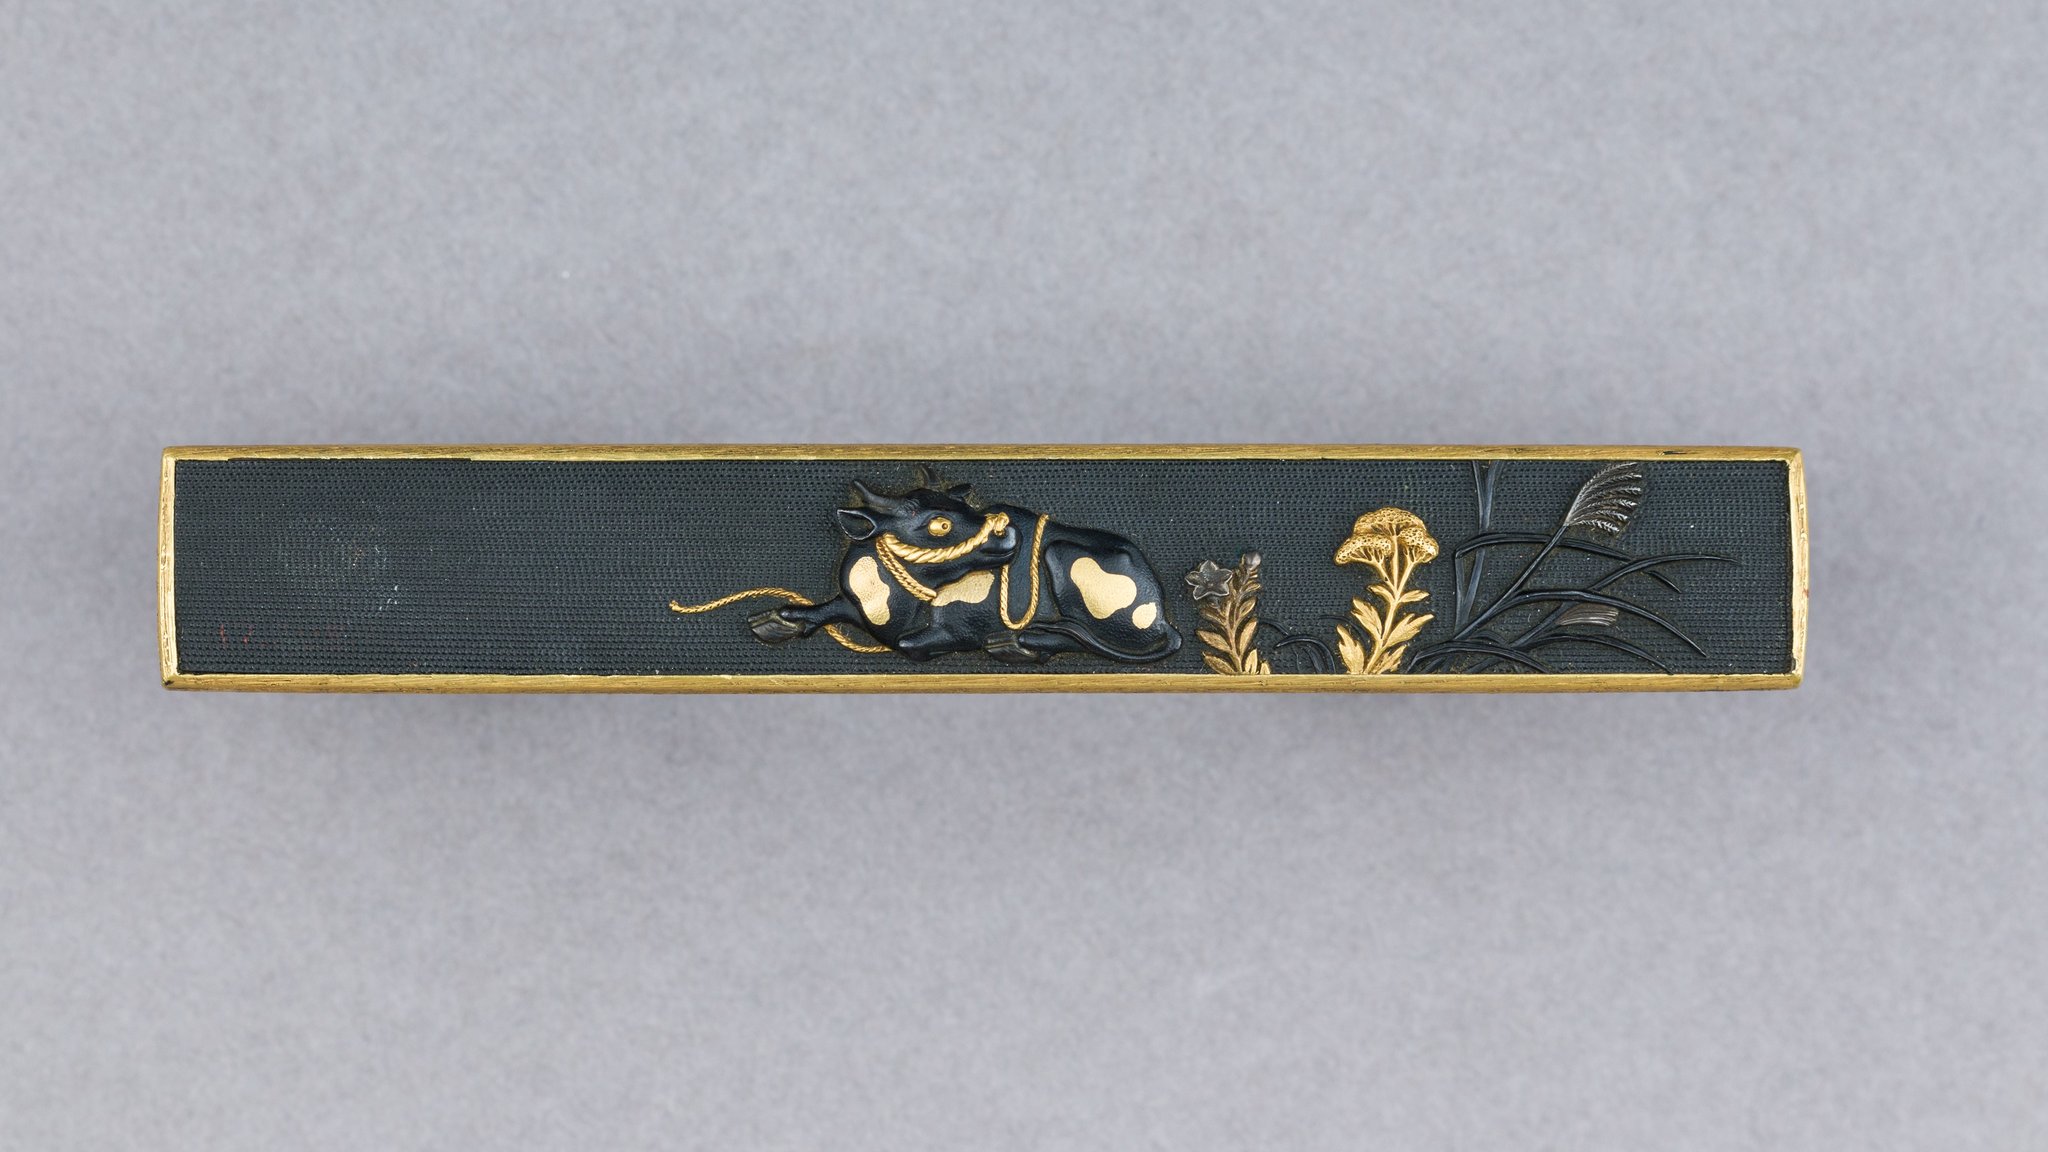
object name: knife handle kozuka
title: Knife Handle (Kozuka)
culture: japanese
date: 1801-1900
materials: gold alloy, gold, silver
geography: japan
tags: ox